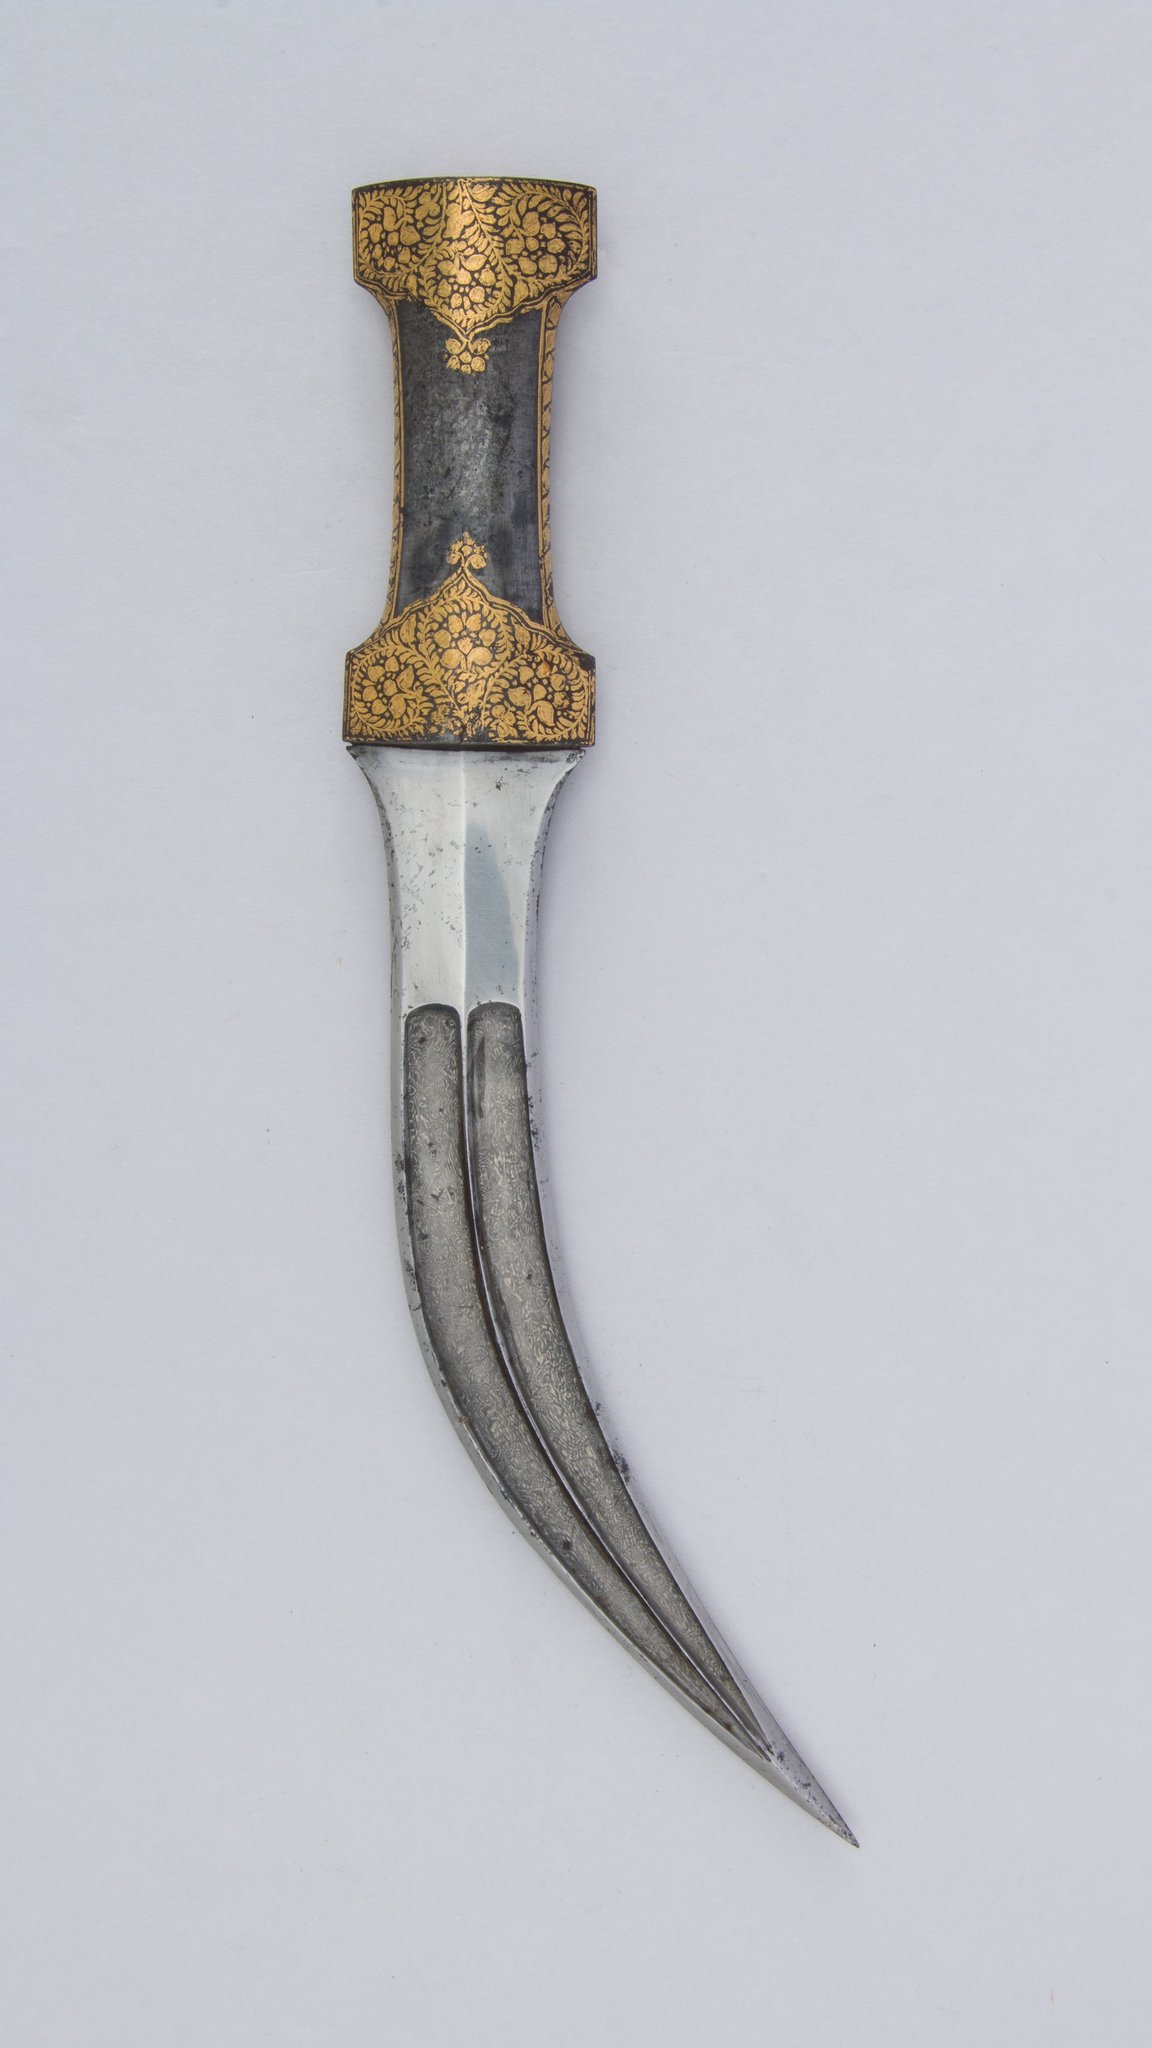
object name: dagger jambiya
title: Dagger (Jambiya)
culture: indian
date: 1701-1900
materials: gold, steel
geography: india